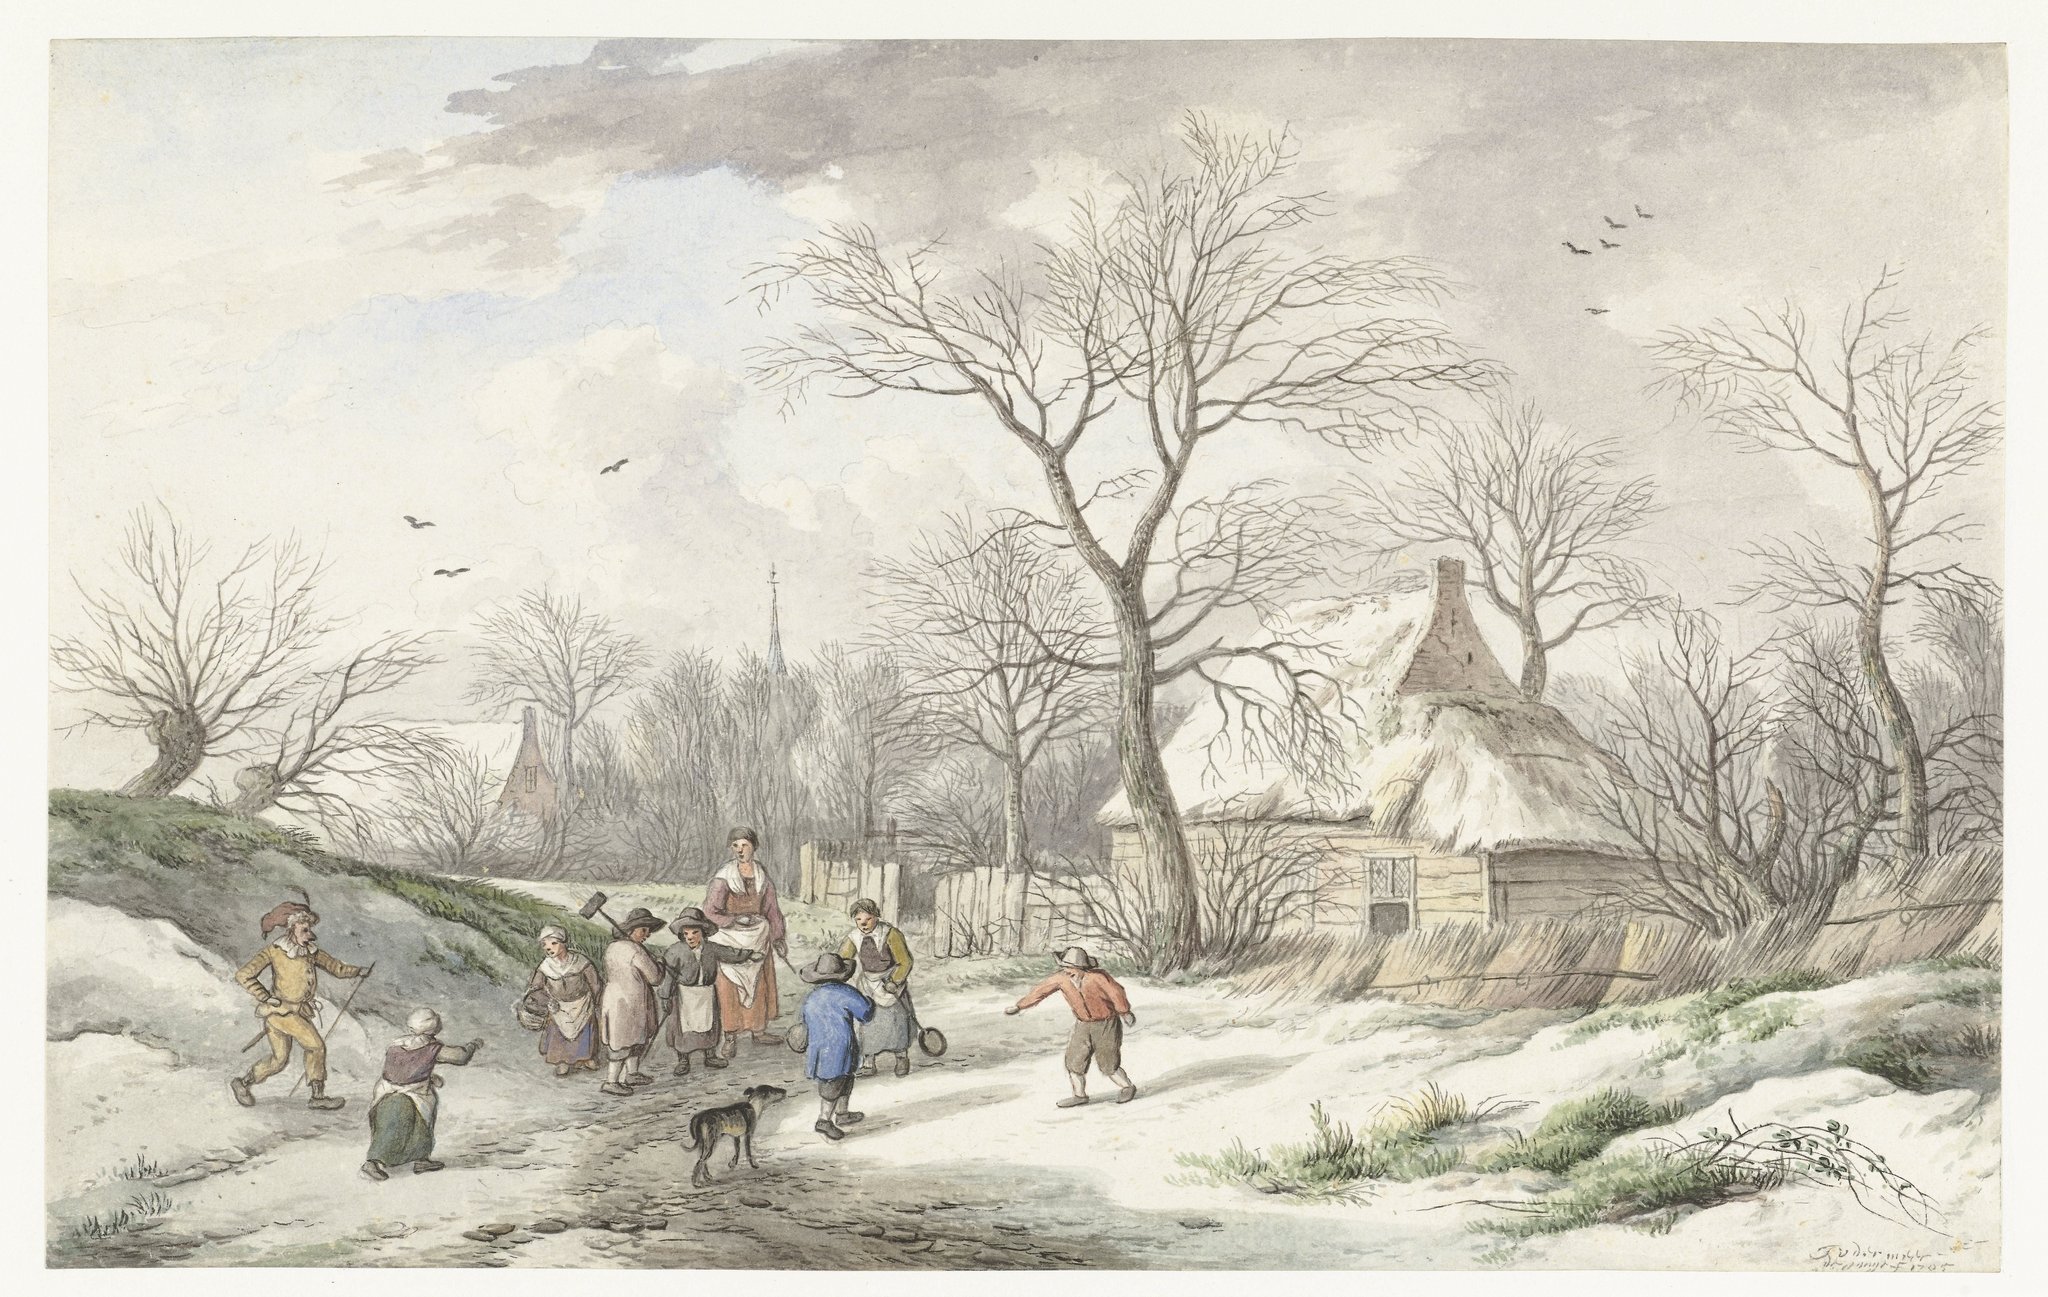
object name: drawing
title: Winter: Assembling for Shrove Tuesday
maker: jan van der meer (ii)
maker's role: draughtsman, print maker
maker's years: 1656-1705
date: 1705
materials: ink, paper, watercolor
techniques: brush, pen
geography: haarlem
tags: prospect of village, silhouette of village, child